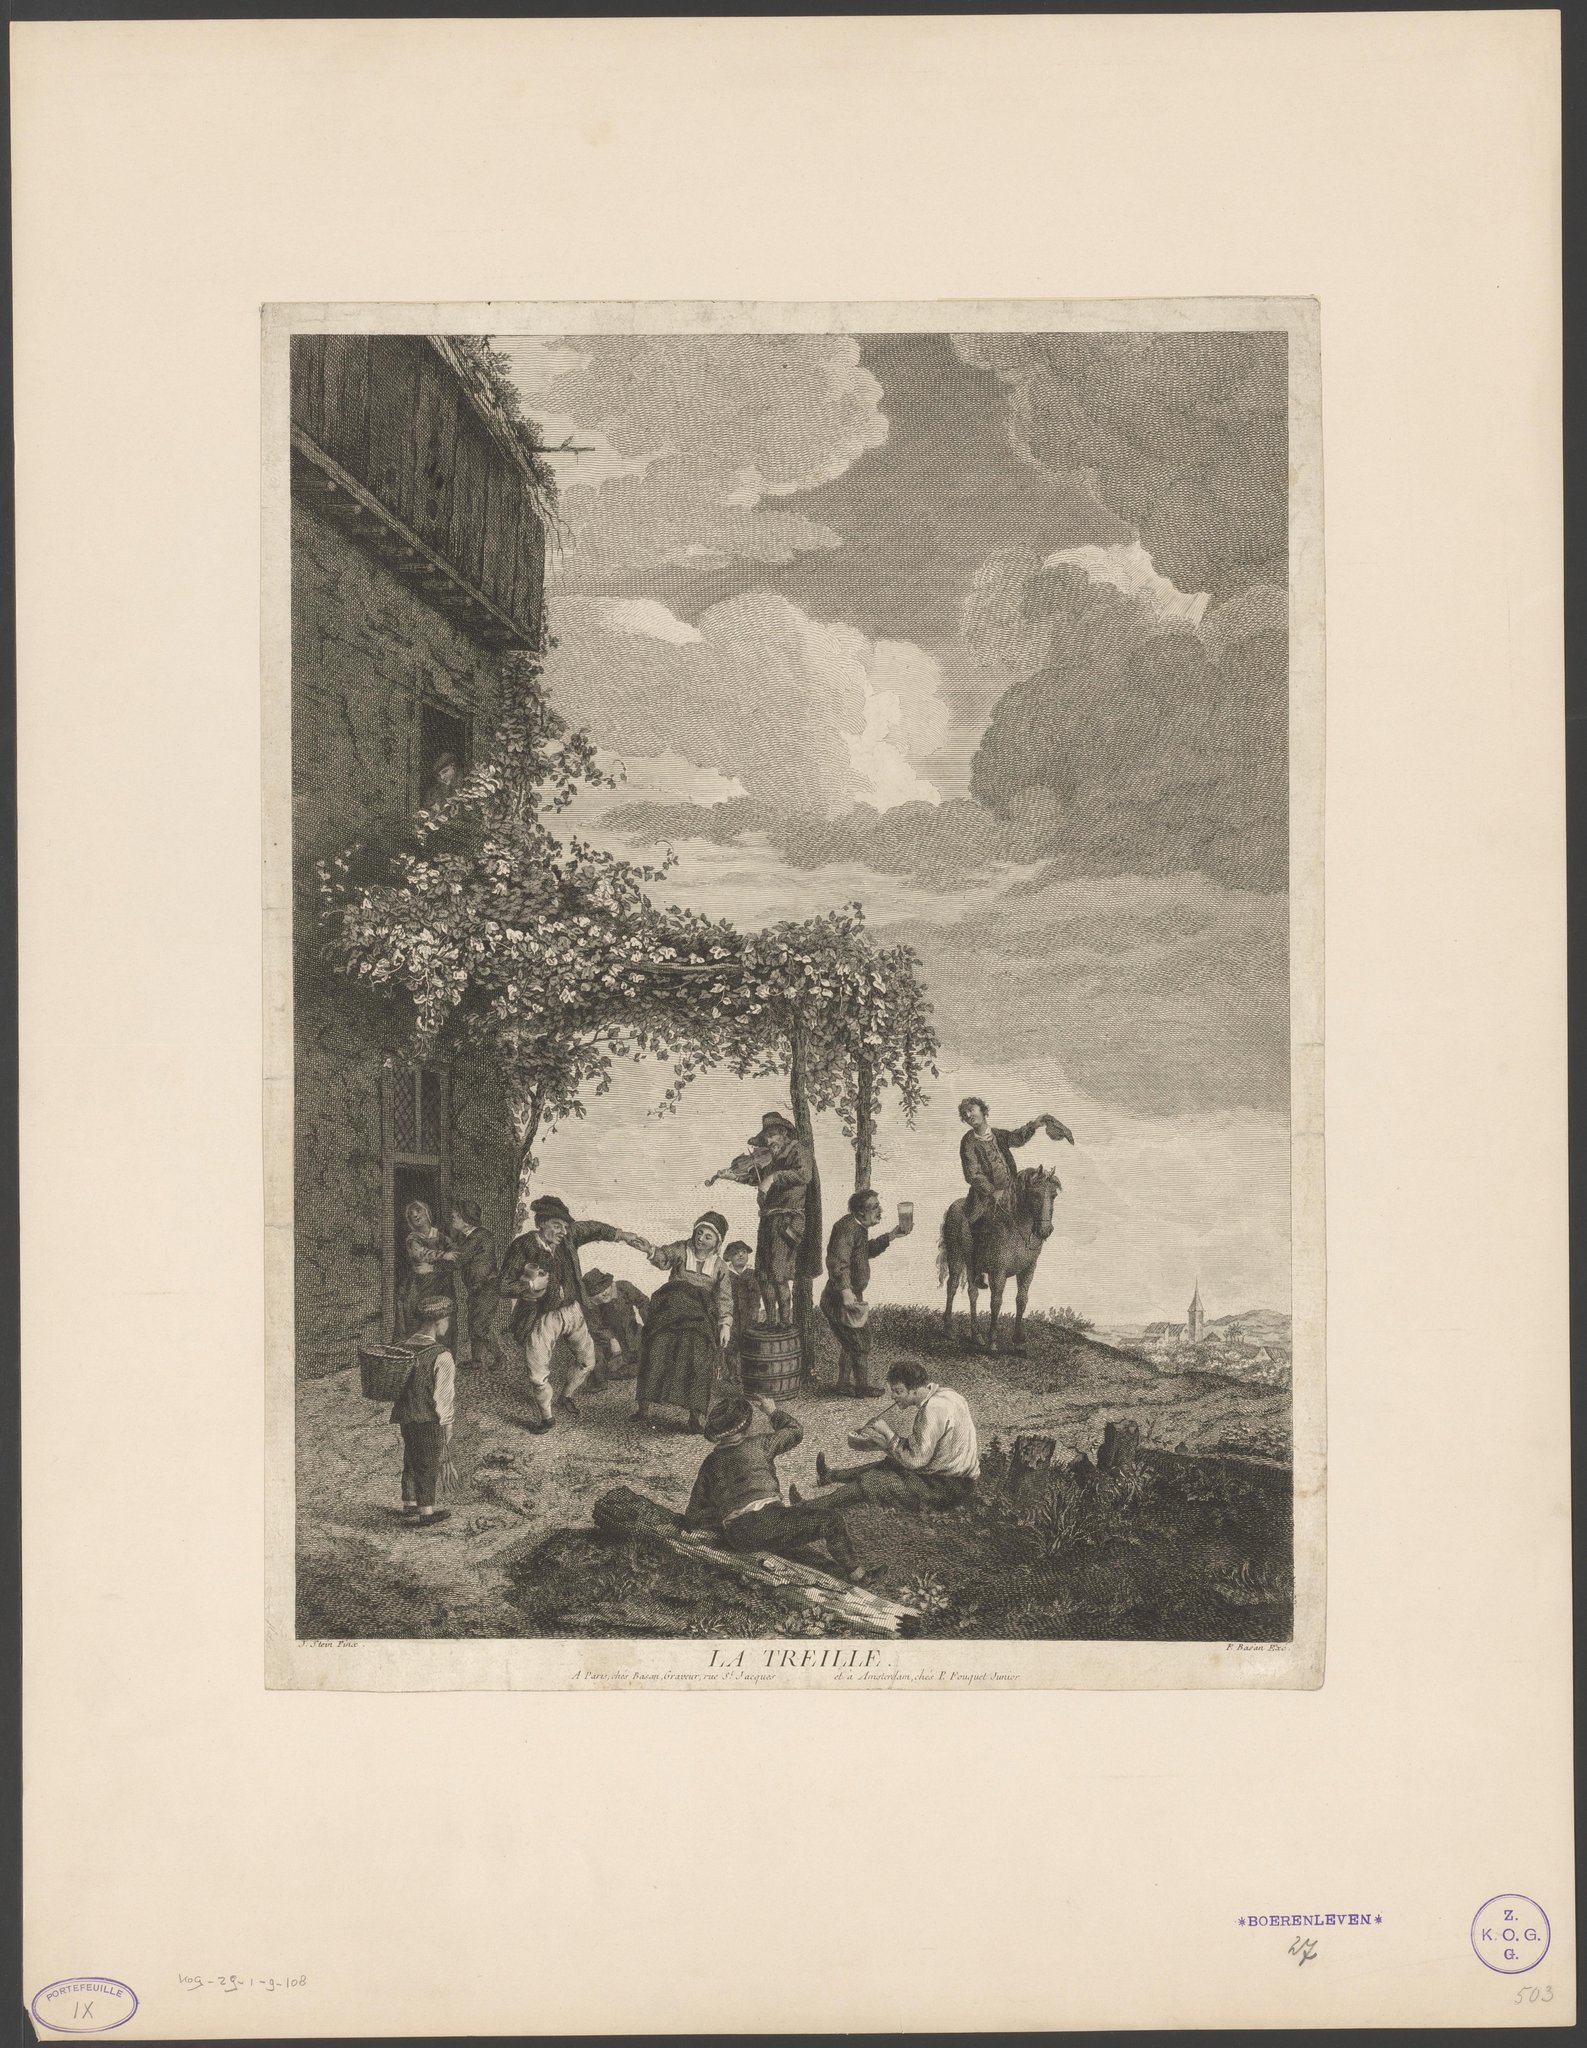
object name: print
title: Dansen en drinkende mensen buiten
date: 1753-1797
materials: paper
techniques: engraving, etching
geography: paris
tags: dancing, violin, fiddle, drinking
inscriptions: collector's mark: Lugt 1641, stamp, stamp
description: Onderwerpsrubrieken binnen de Atlas Zeden en Gewoonten: Handel, nijverheid en verkeer, Boerenleven.